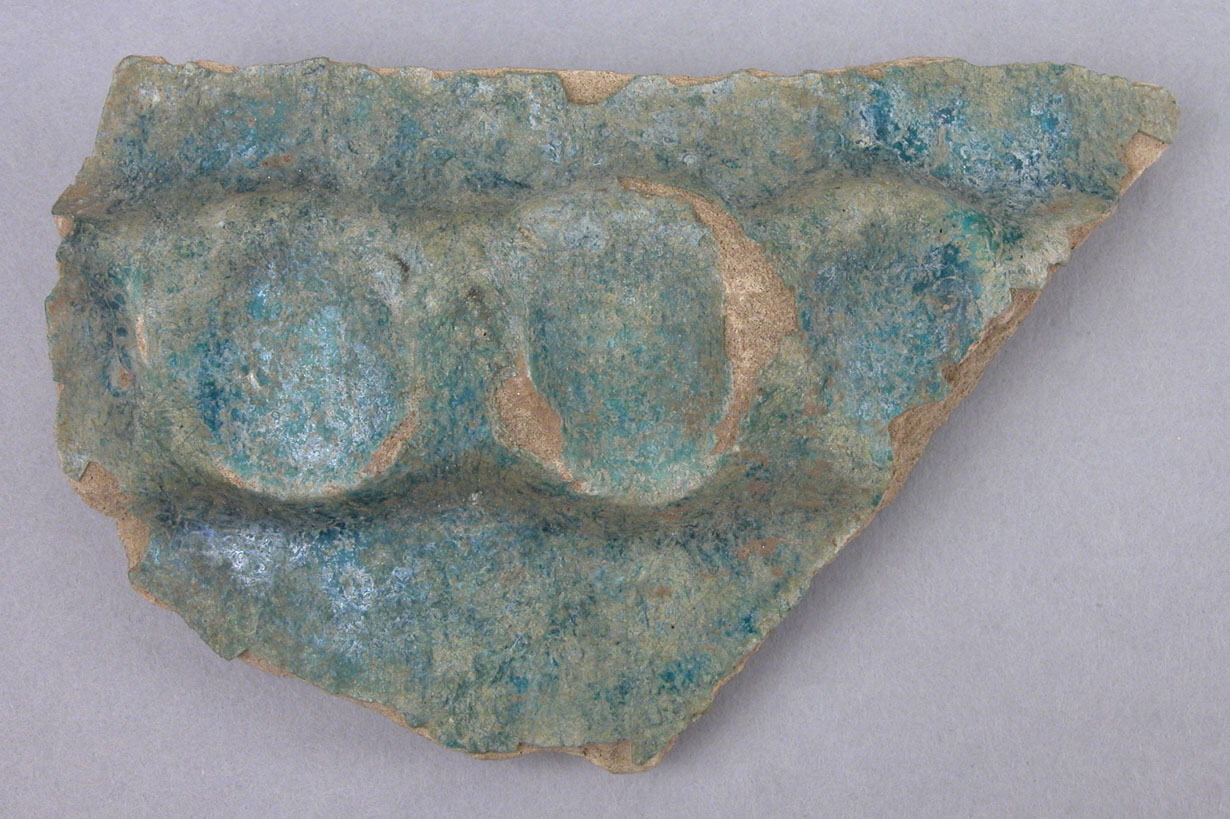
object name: fragment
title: Fragment of a Closed Vessel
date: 601-900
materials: earthenware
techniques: glazing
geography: iraq